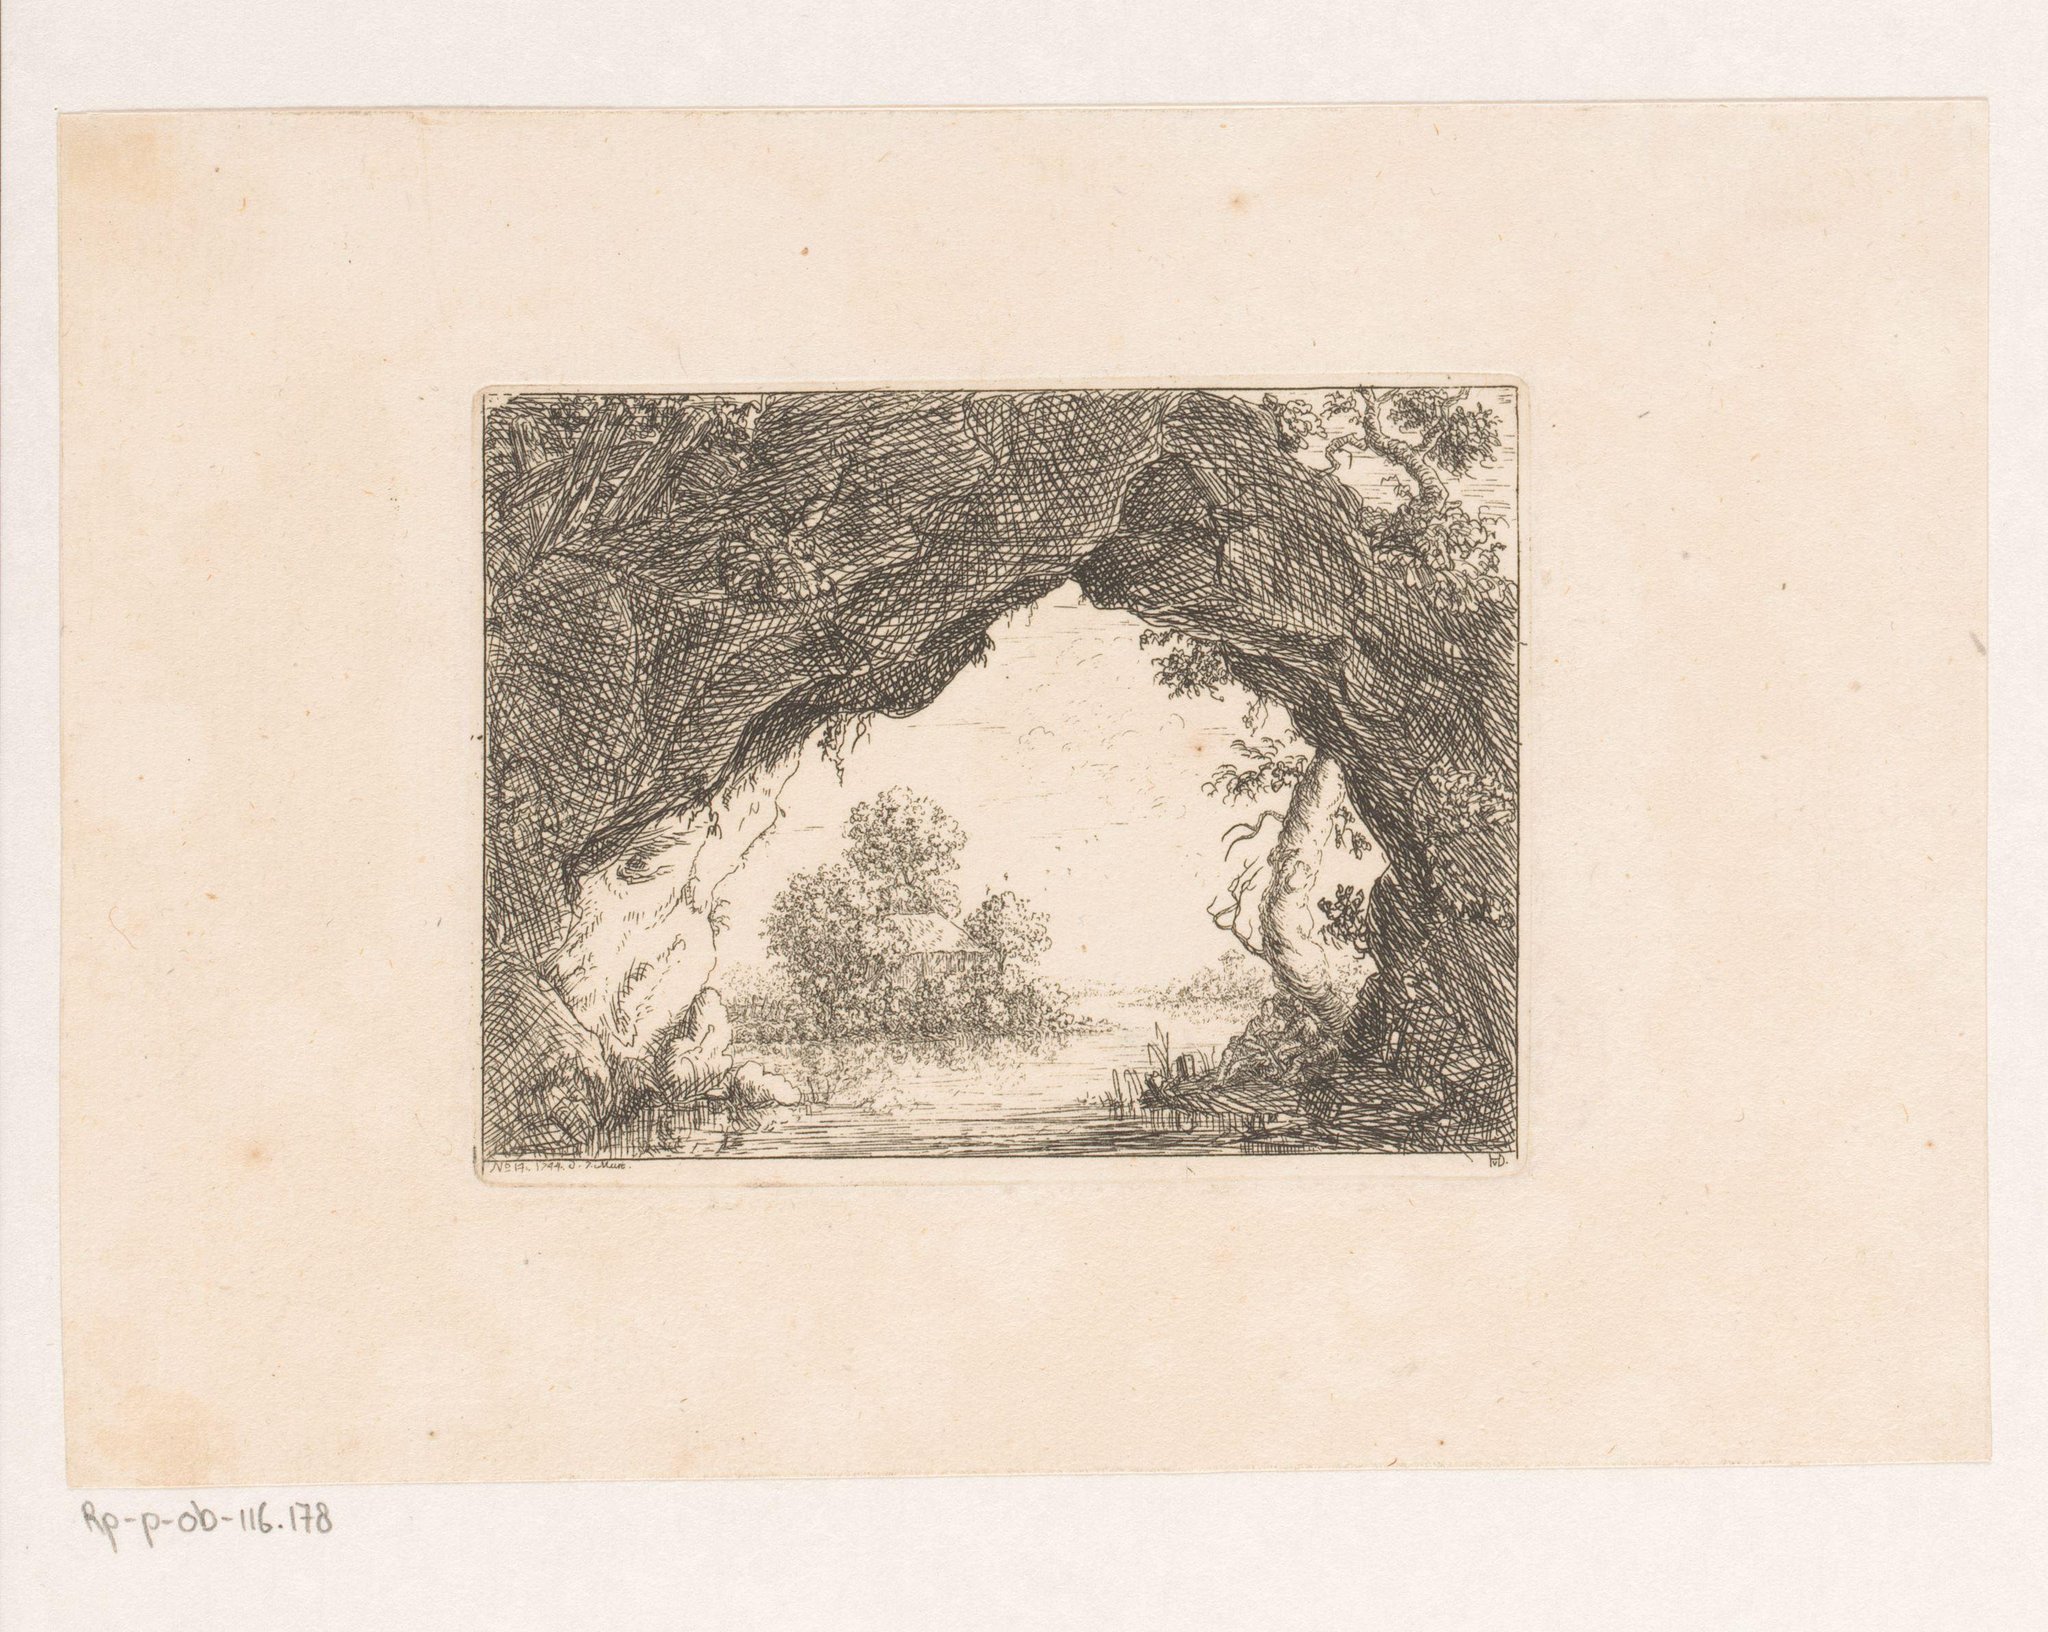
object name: print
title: Landschap met onder een grot doorlopende rivier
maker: christian ludwig von hagedorn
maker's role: painter, print maker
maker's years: 1712-1780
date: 1744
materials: paper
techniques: etching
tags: cave, grotto, river (+ landscape with figures, staffage)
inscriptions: collector's mark: Lugt 240